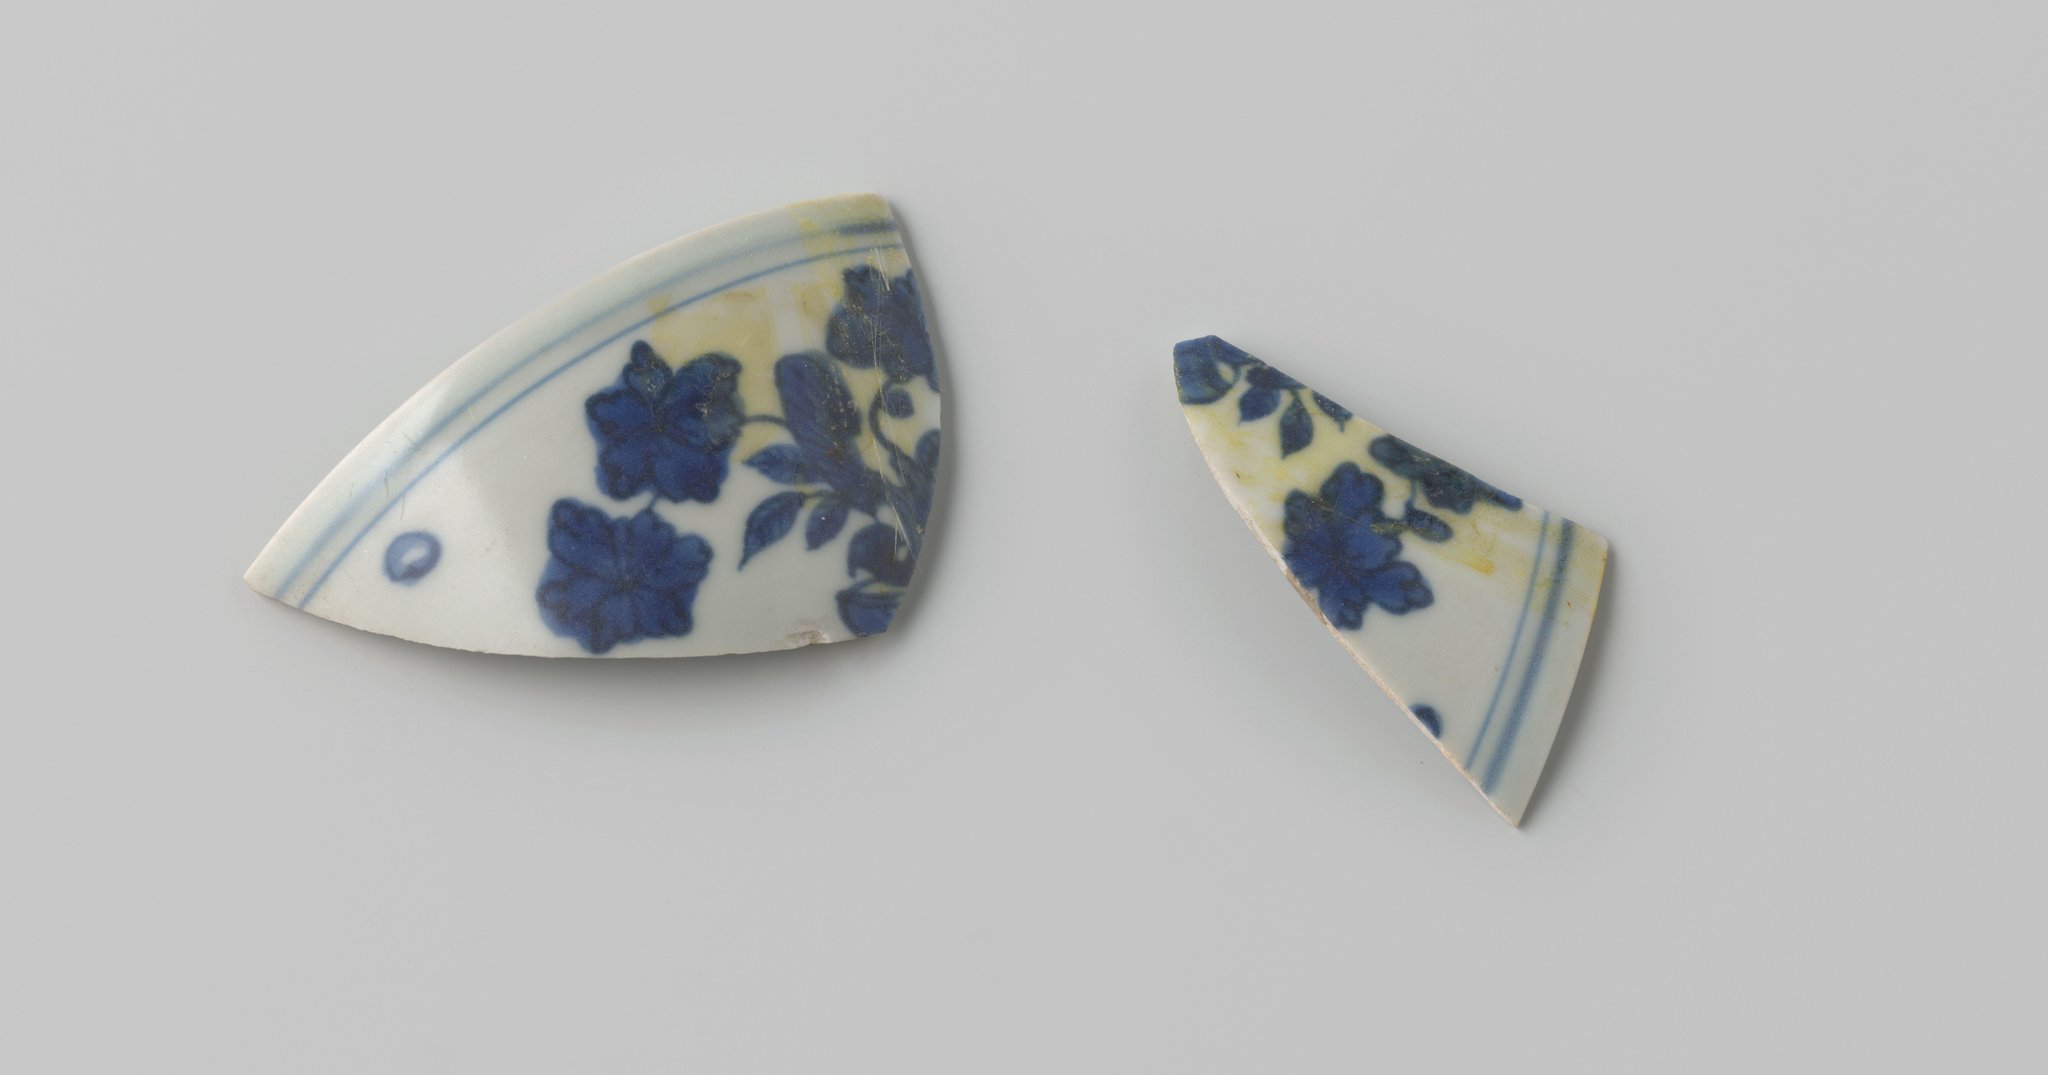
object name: sherd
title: Scherven van een kom uit V.O.C.-schip de 'Witte Leeuw'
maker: Anonymous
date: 1613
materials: porcelain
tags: verenigde oostindische compagnie, sint-helena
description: Scherven van een kom uit V.O.C.-schip de 'Witte Leeuw'.